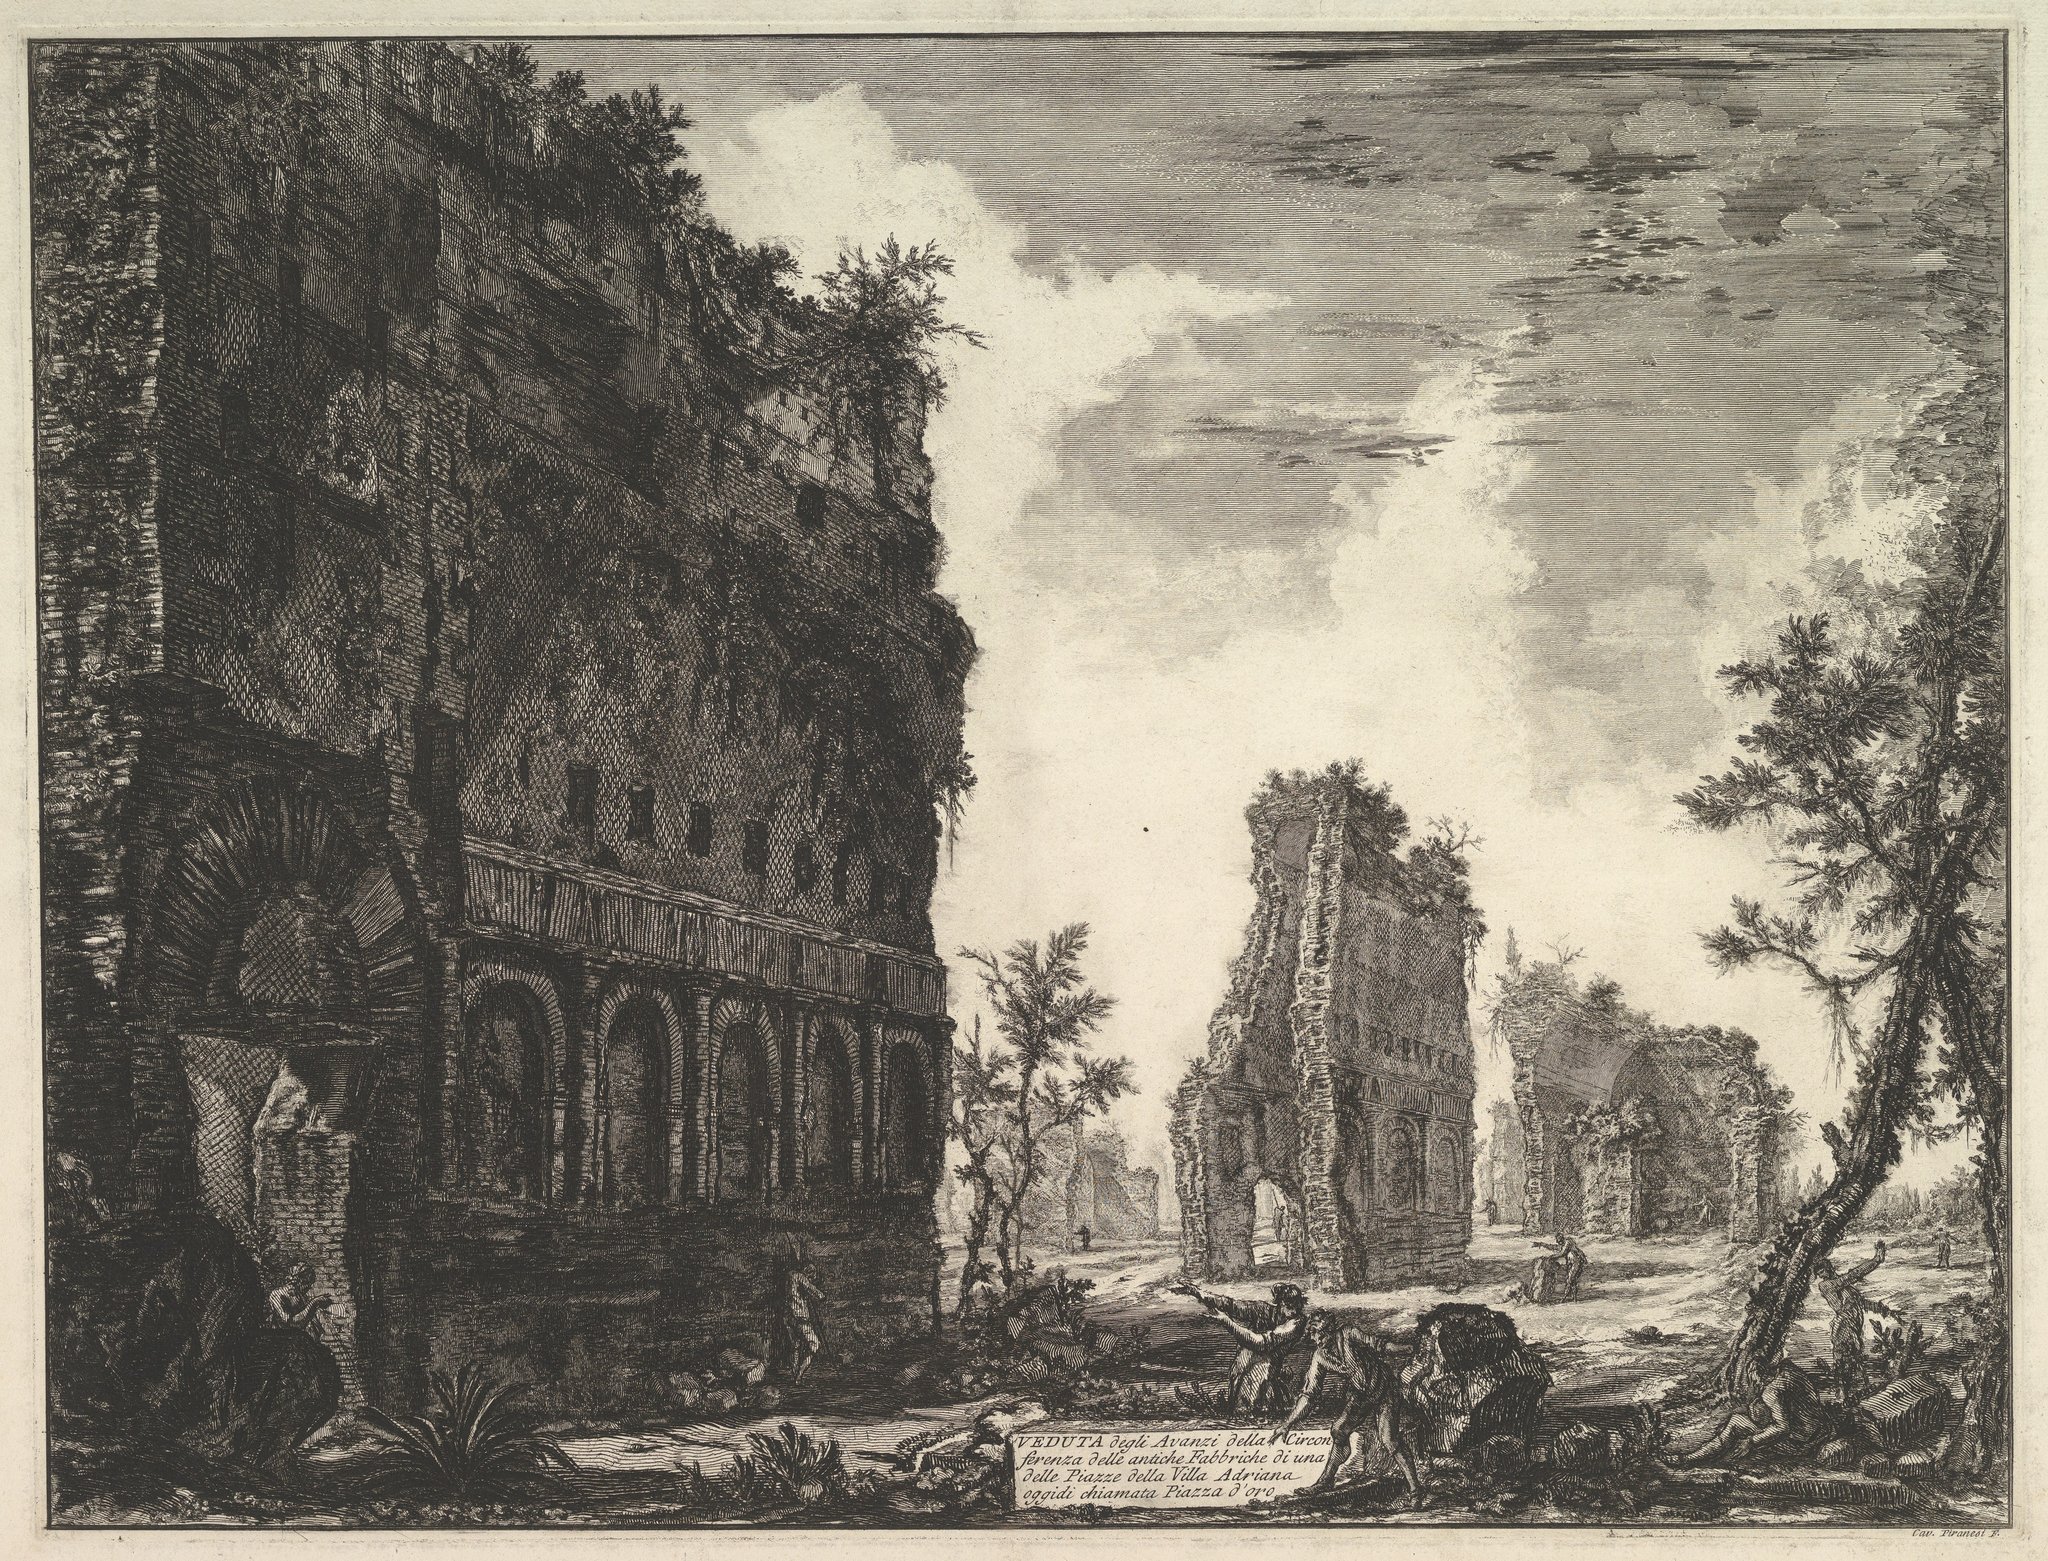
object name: print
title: Hadrian's Villa: The Piazza d'Oro (Piazza of Gold) (Veduta degli Avanzi della Circonferenza delle antiche Fabbriche di una delle Piazze della Villa Adriana oggidi chiamata Piazza d'oro)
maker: giovanni battista piranesi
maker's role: artist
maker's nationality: italian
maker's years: 1720-1778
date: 1776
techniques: etching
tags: human figures,ruins